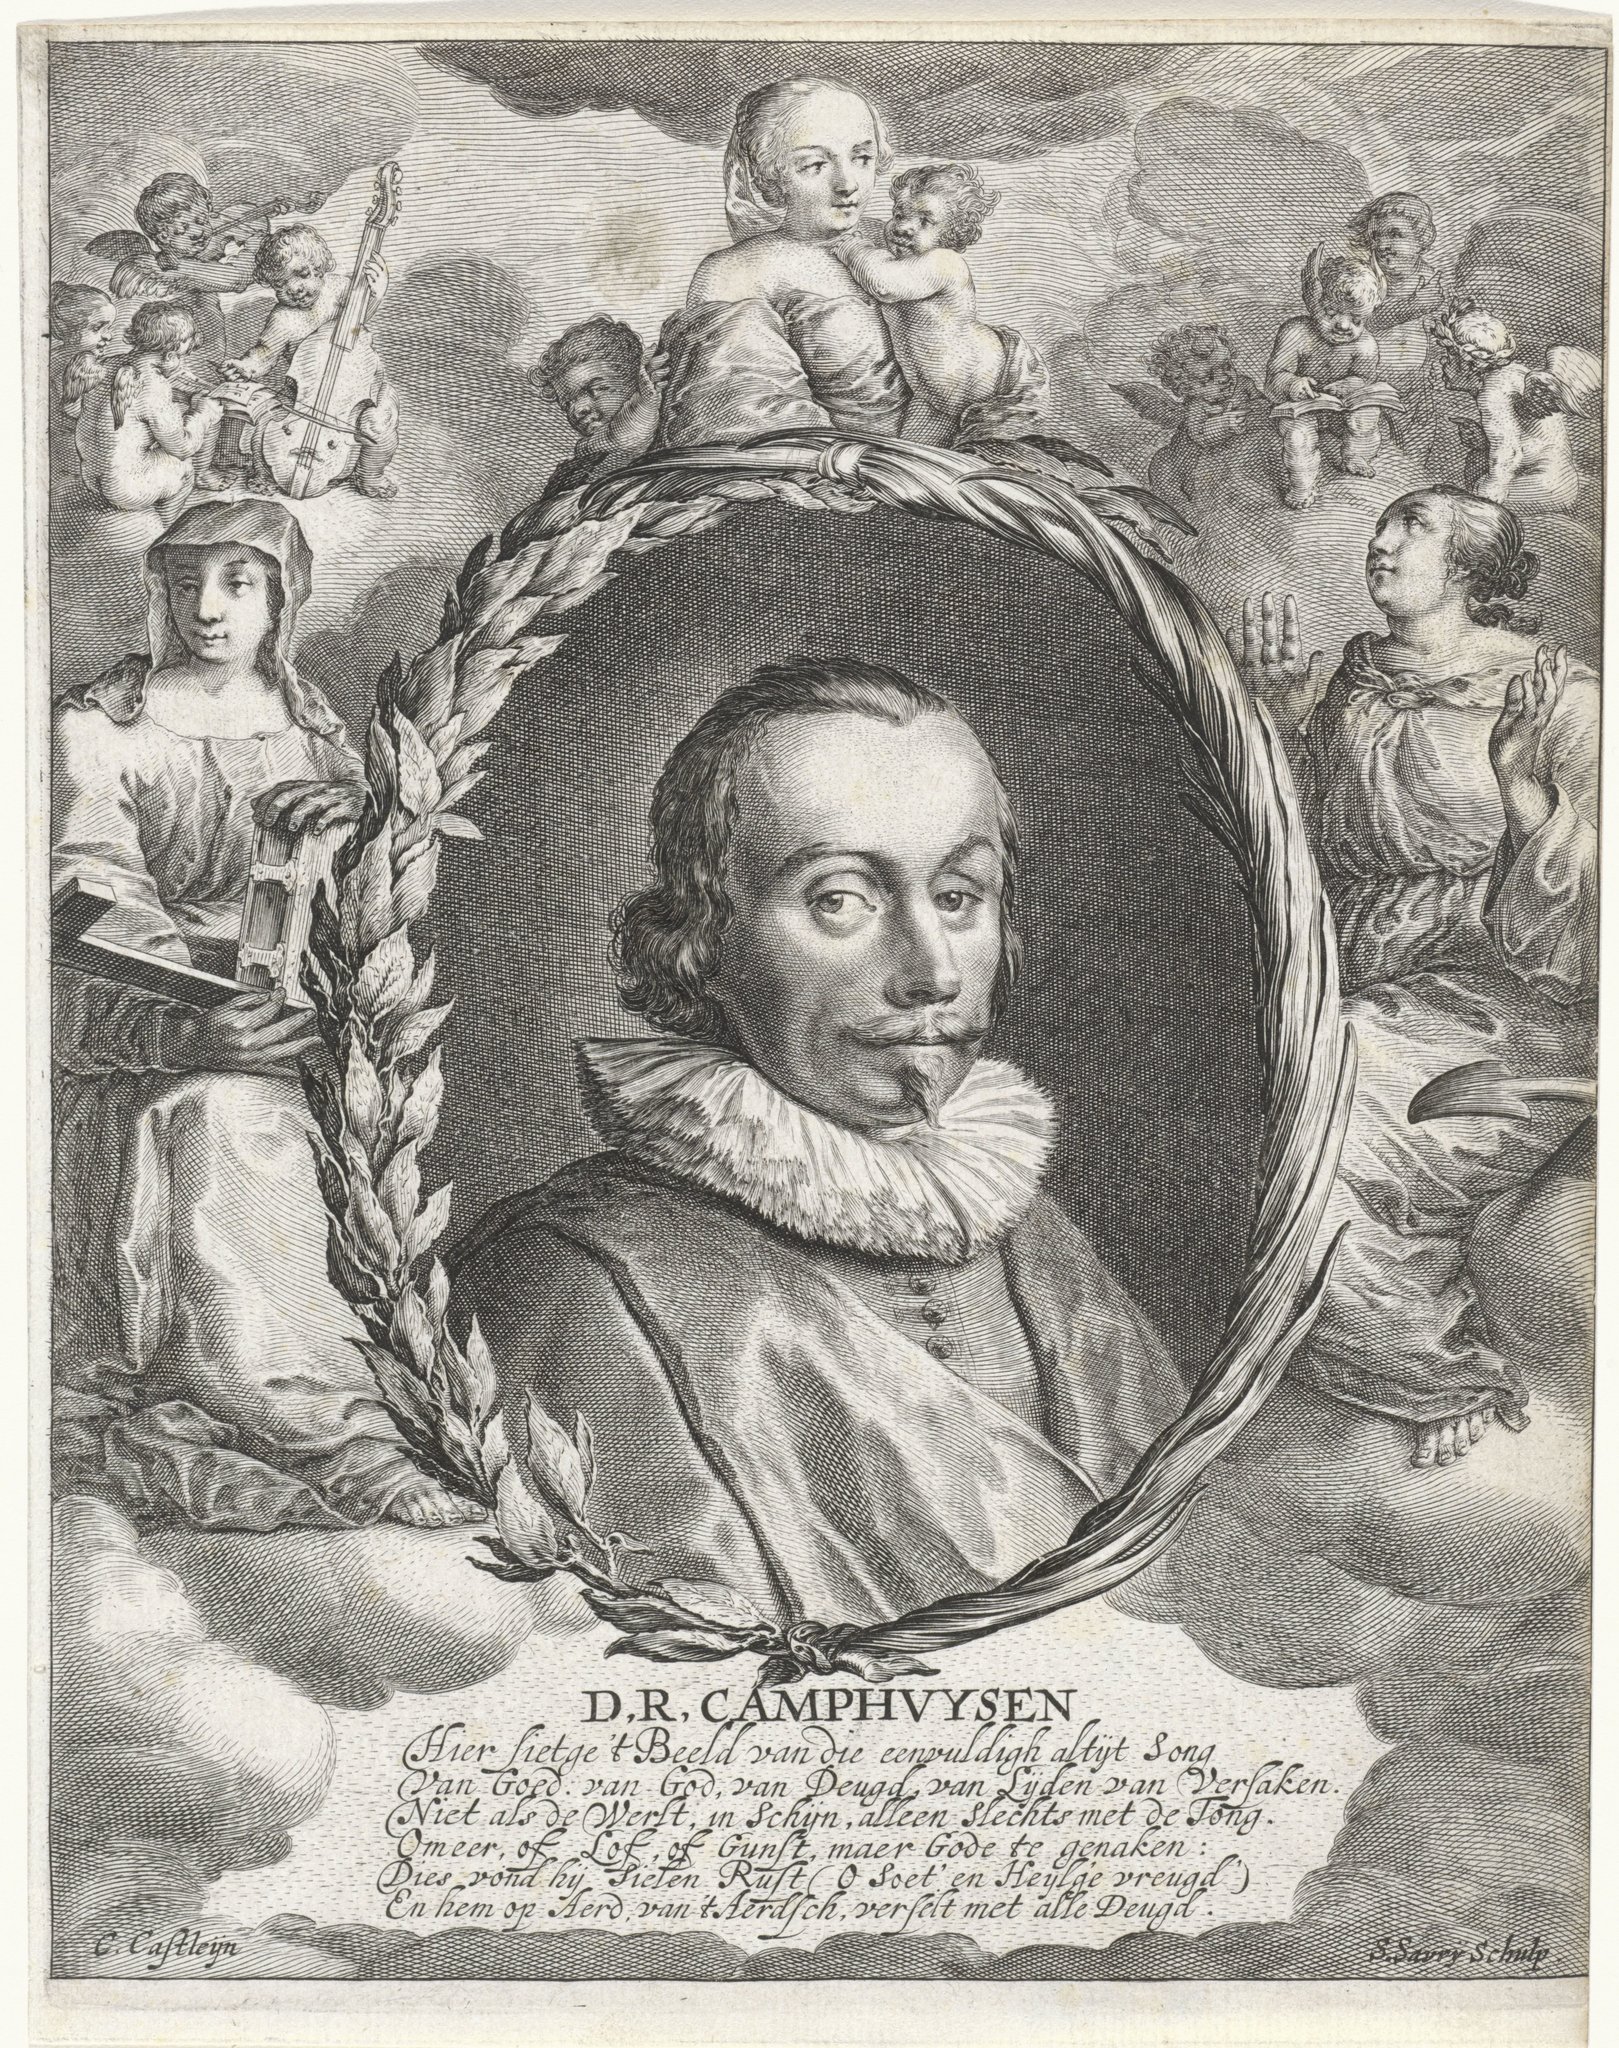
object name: print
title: Portret van de theoloog Dirck Rafaelsz Camphuysen, omgeven door allegorische figuren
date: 1635-1665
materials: paper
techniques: engraving, etching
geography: amsterdam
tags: gorinchem, dokkum, dichter, theoloog, dirck rafaelsz. camphuysen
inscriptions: collector's mark: Lugt 240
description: Als auteursportret opgenomen in: Camphuysen, Dirck Rafaelsz. Stichtelycke rymen. Amsterdam: Abraham de Wees e.a., 1652. Tevens in zijn Theologische Werken, uitgegeven door Jan Riewertsz en Jan Hendricksz Boom in 1661 en Jan Rieuwertsz alleen in 1672 en 1682.